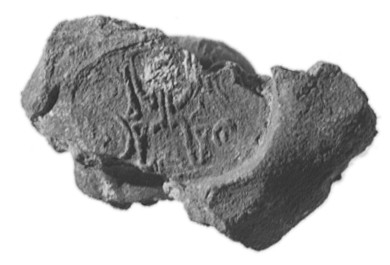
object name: sealing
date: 2030-1640 BCE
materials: clay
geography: egypt